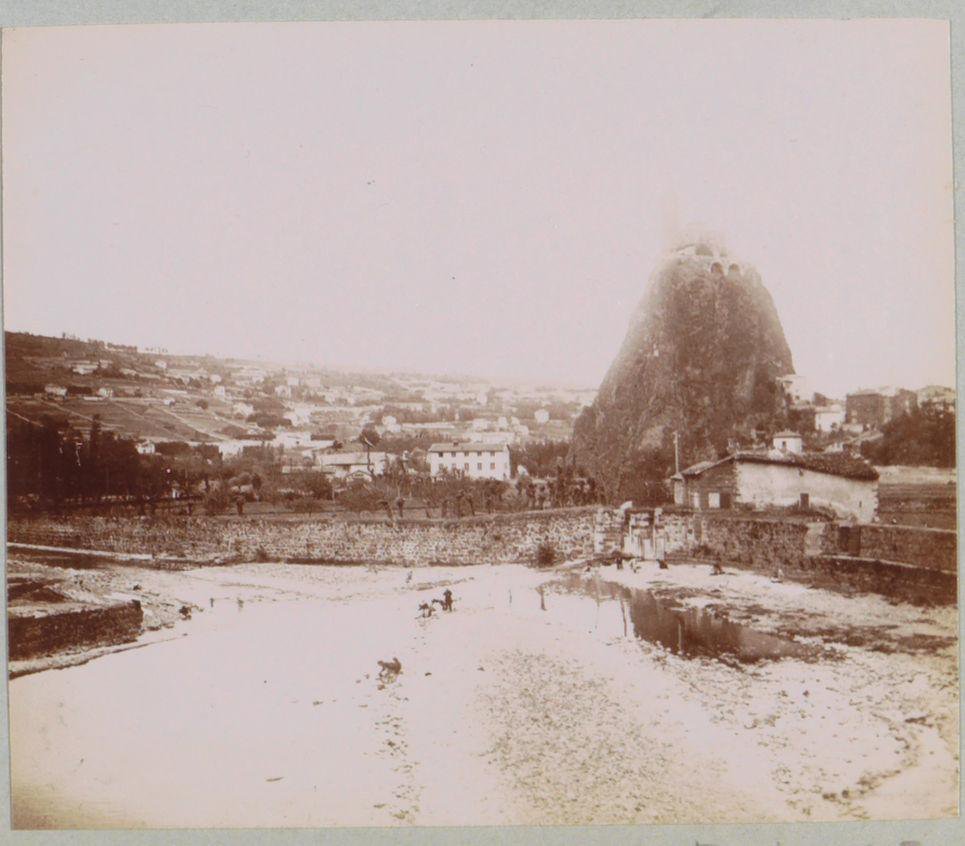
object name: photograph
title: Gezicht op een rotsformatie in Le Puy-en-Velay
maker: delizy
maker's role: manufacturer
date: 1902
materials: paper, photographic support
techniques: gelatin silver print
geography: le puy-en-velay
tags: prospect of village, silhouette of village, rock-formations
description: Onderdeel van Fotoalbum van een Franse amateurfotograaf met opnames van uitstapjes in Frankrijk, Spanje, België, Luxemburg en Nederland, de eerste automobielen en autoraces.